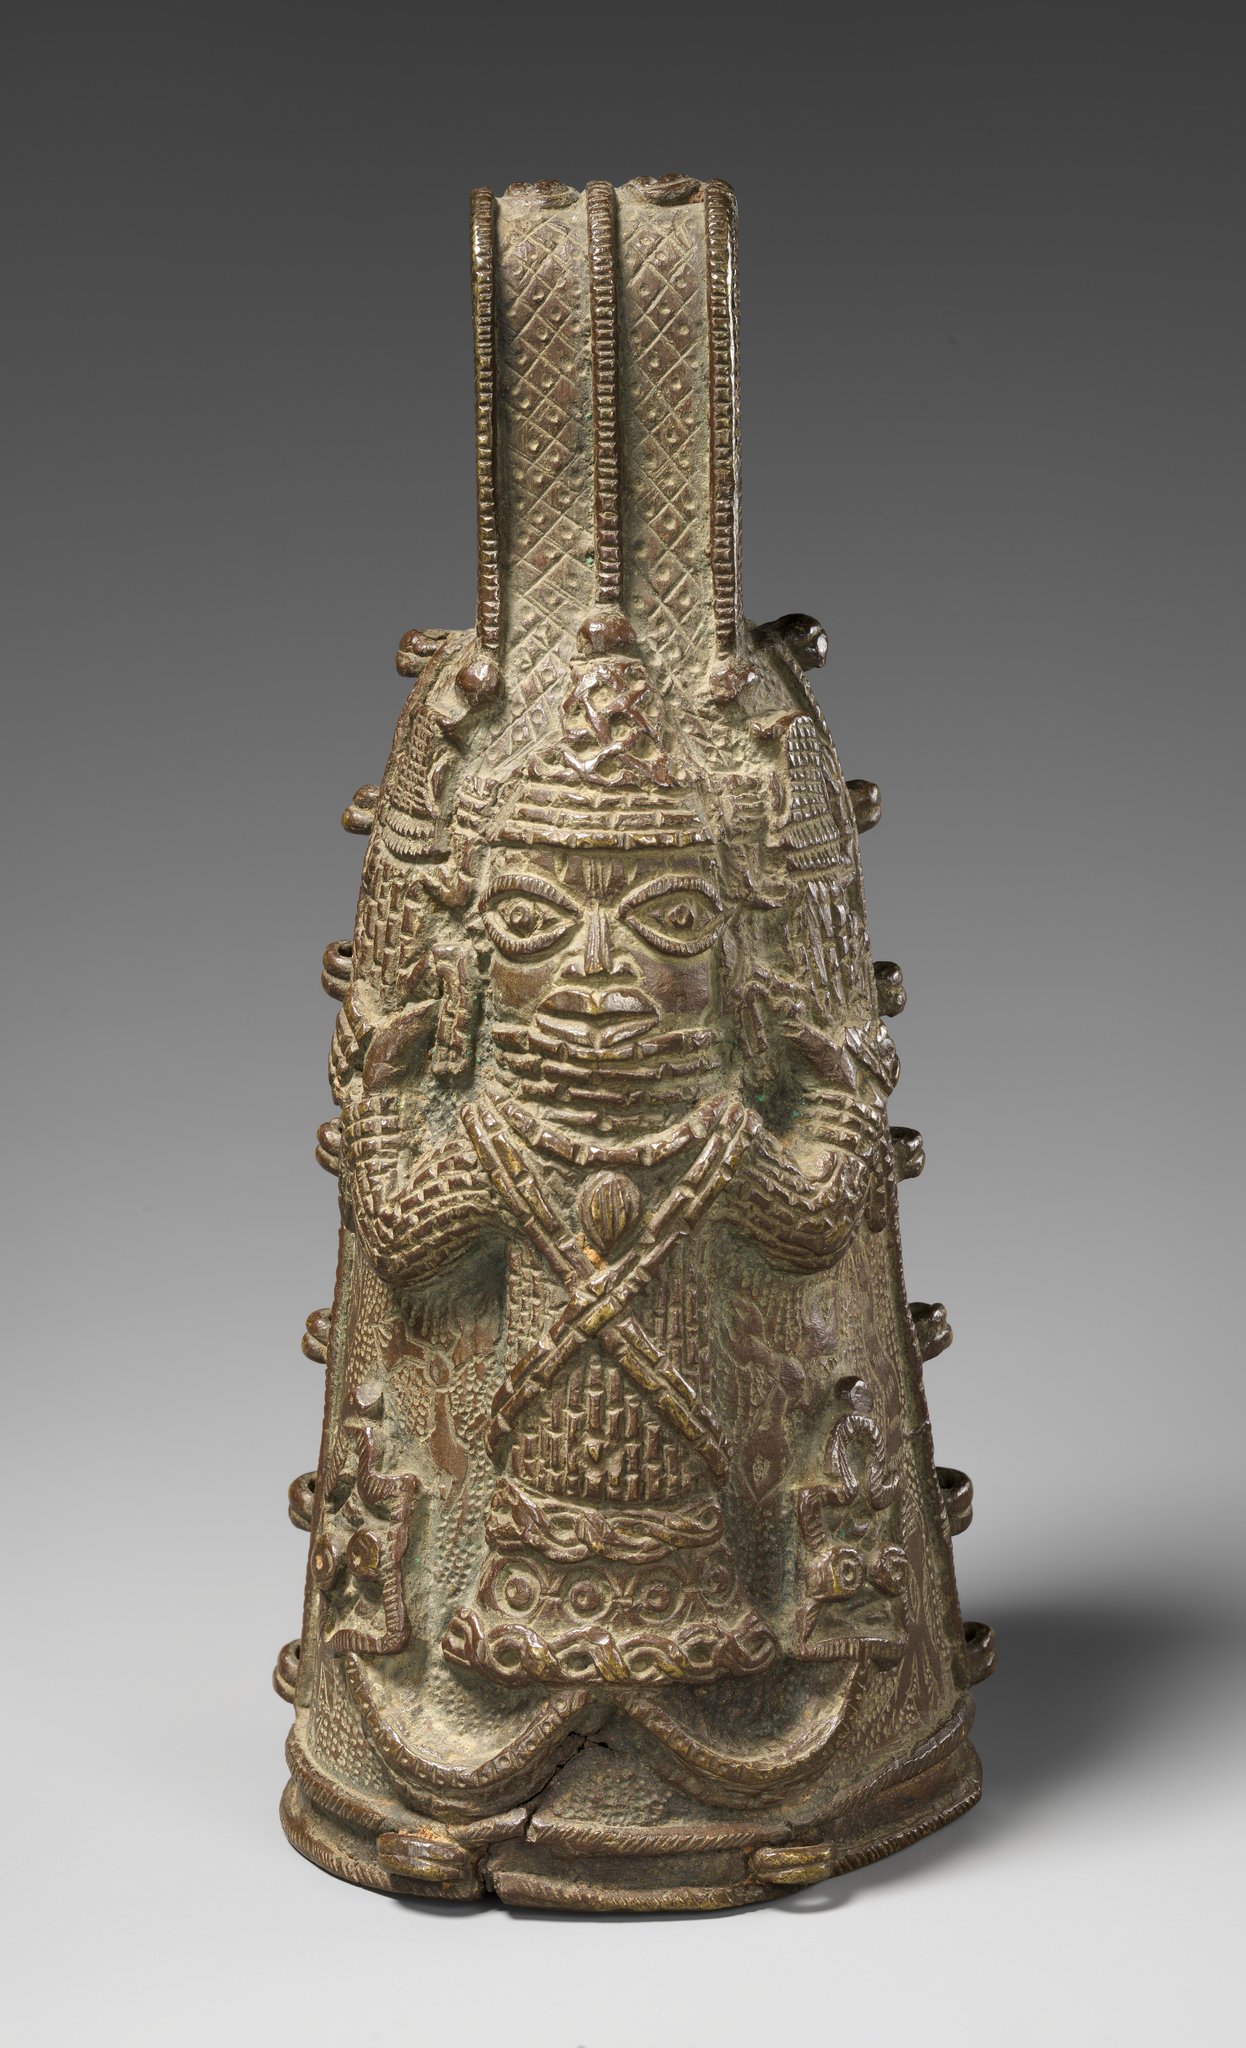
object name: bell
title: Altar bell with a mudfish-legged ọ́bà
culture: edo period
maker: ìgùn ẹ́rọ̀nwwọ̀n (brass-casting guild) artists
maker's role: artist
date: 1701-1900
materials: brass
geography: nigeria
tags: kings,men,fish